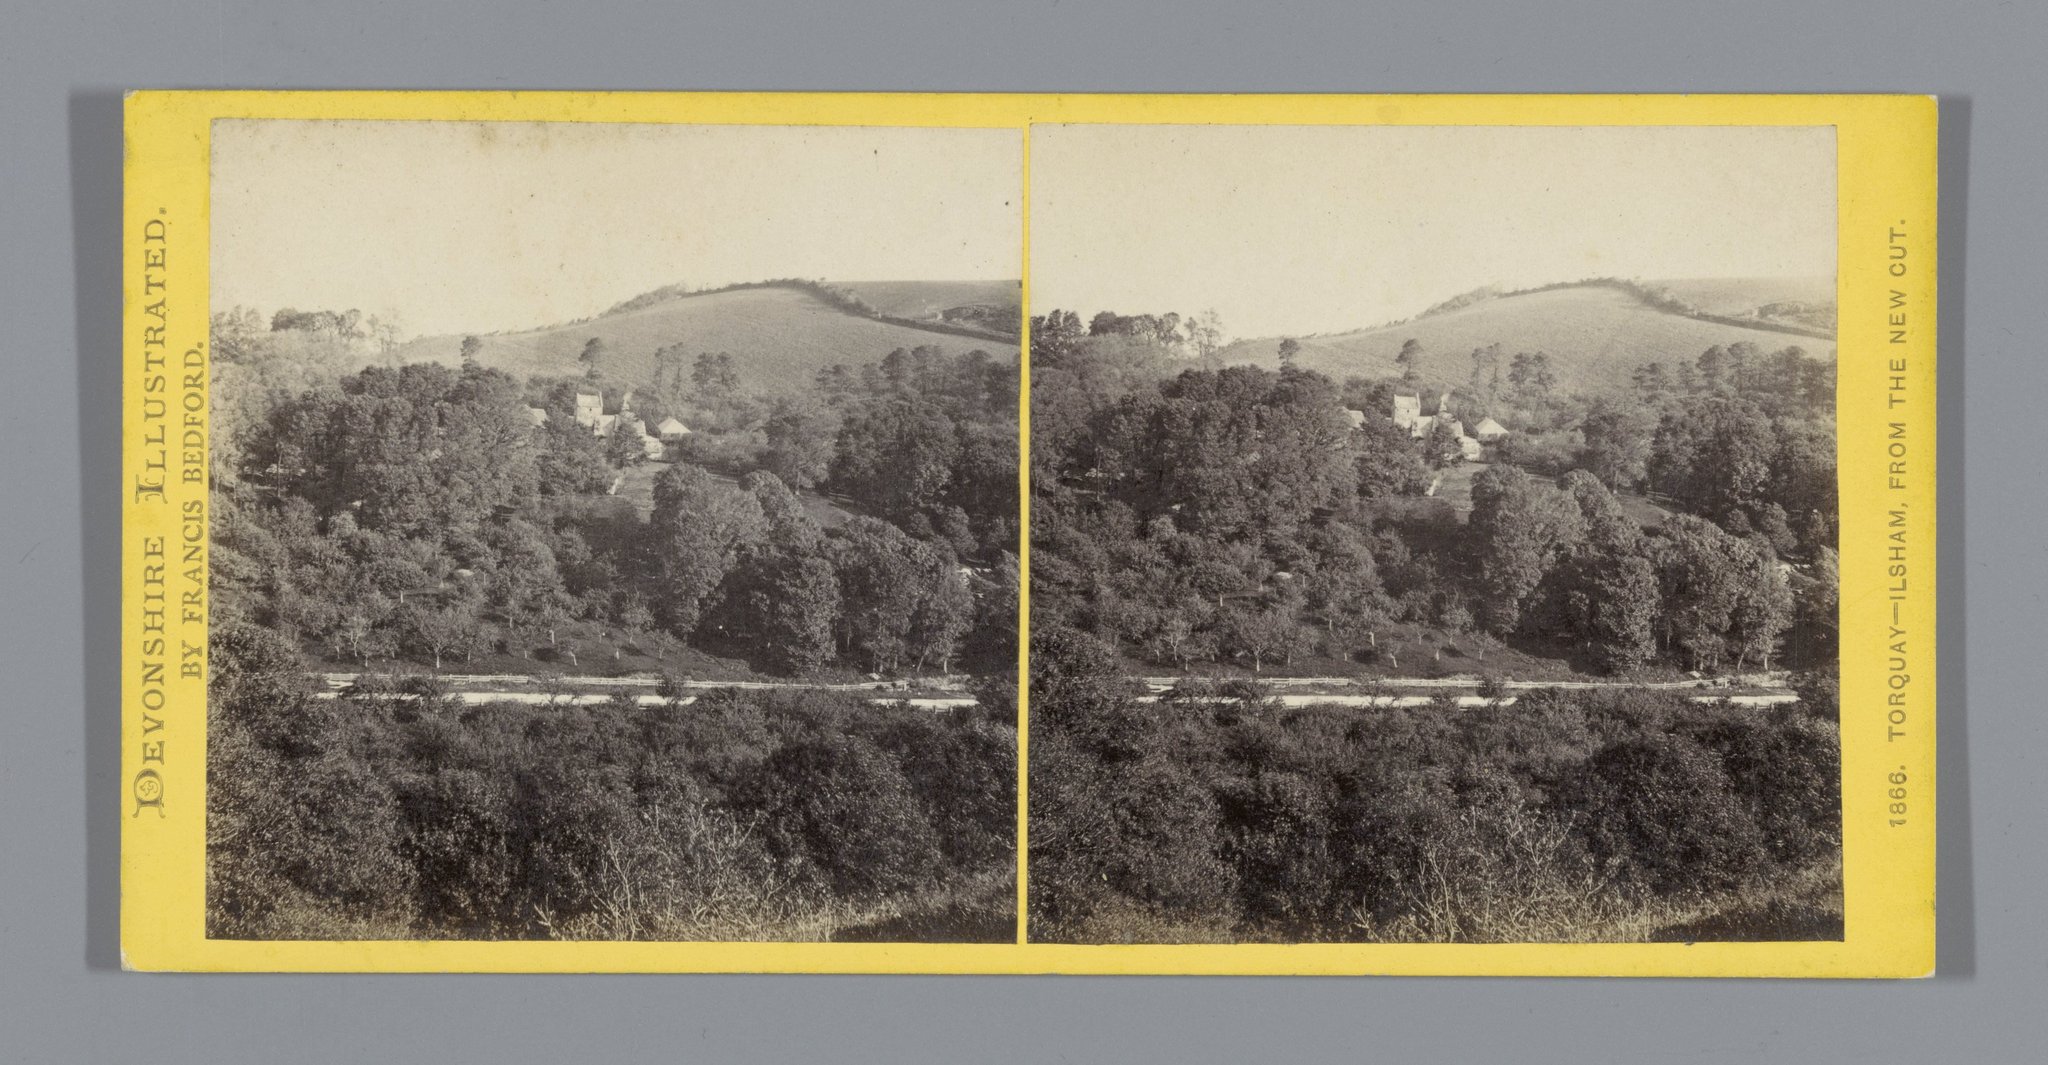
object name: stereograph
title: Heuvellandschap nabij Torquay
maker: francis bedford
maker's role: print maker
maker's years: 1815-1894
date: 1850-1880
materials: cardboard, photographic support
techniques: albumen print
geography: torquay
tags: low hill country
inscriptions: inscription: ‘Devonshire Illustrated. by Francis Bedford.’, number: ‘1866.’